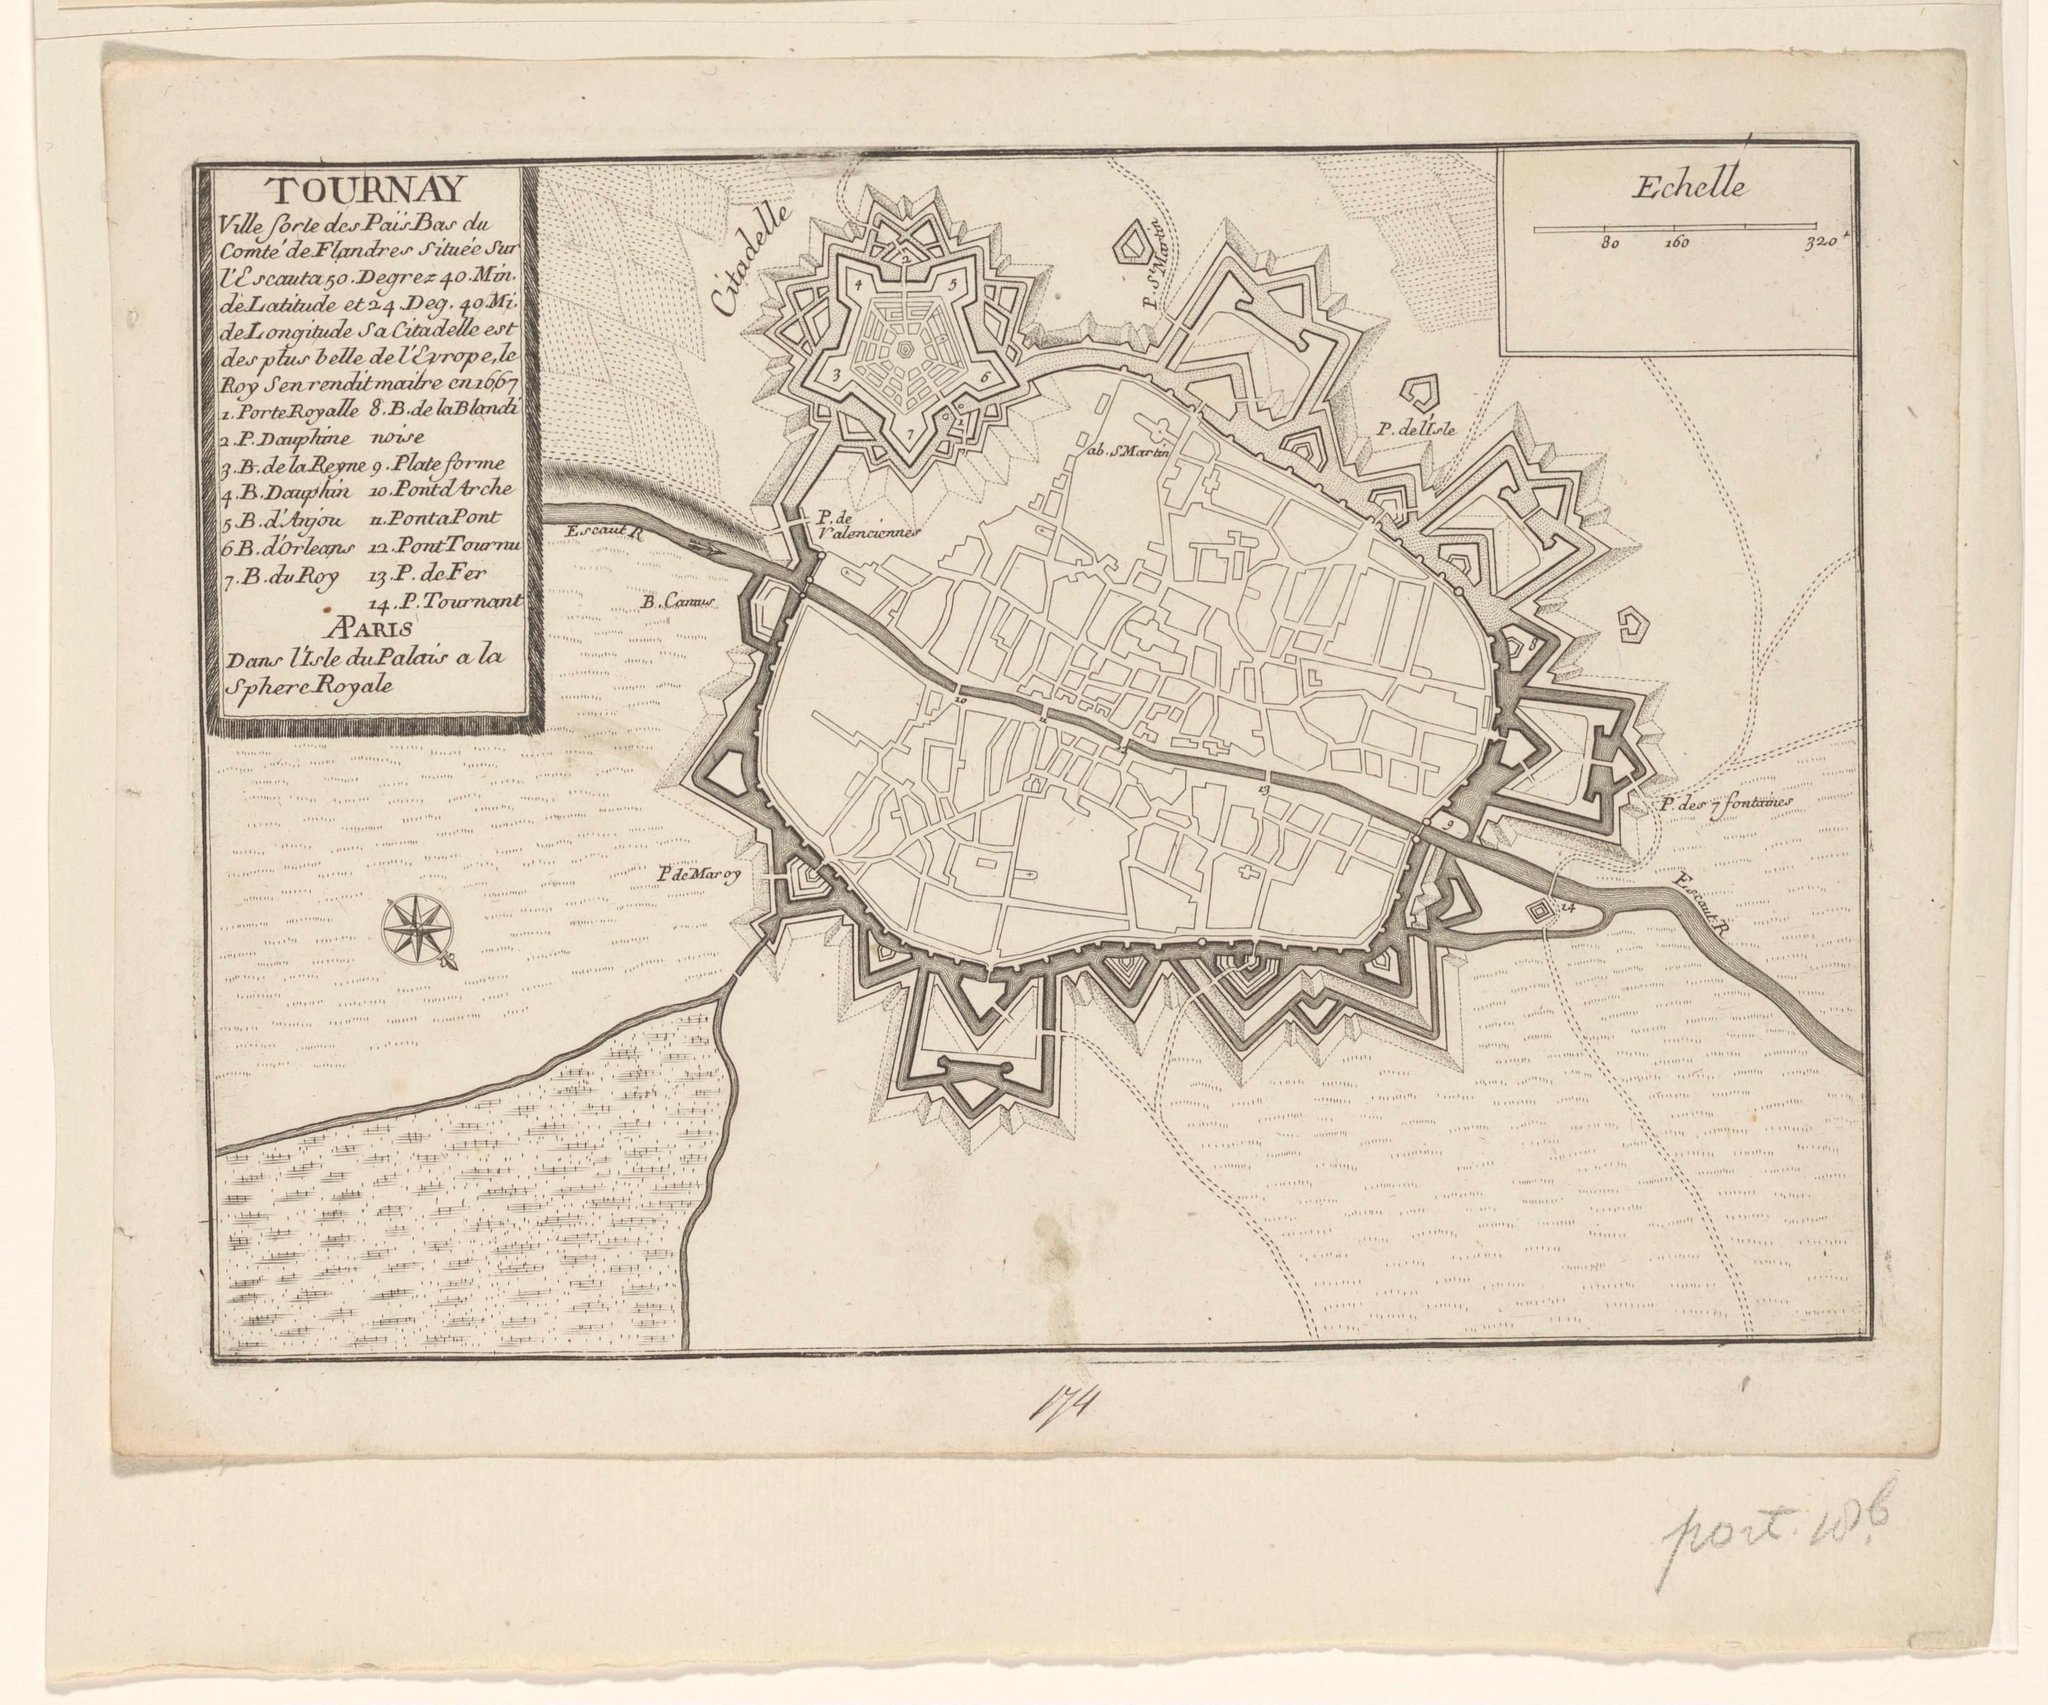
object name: area plan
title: Vestingplattegrond van Doornik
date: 1685-1728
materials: paper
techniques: engraving, etching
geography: paris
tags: fortified city, maps of cities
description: Vestingplattegrond van Doornik. Linksboven een cartouche met de titel, een beschrijving van Doornik en een legenda 1-14. Rechtsboven een cartouche met schaalstok: Echelle 320.